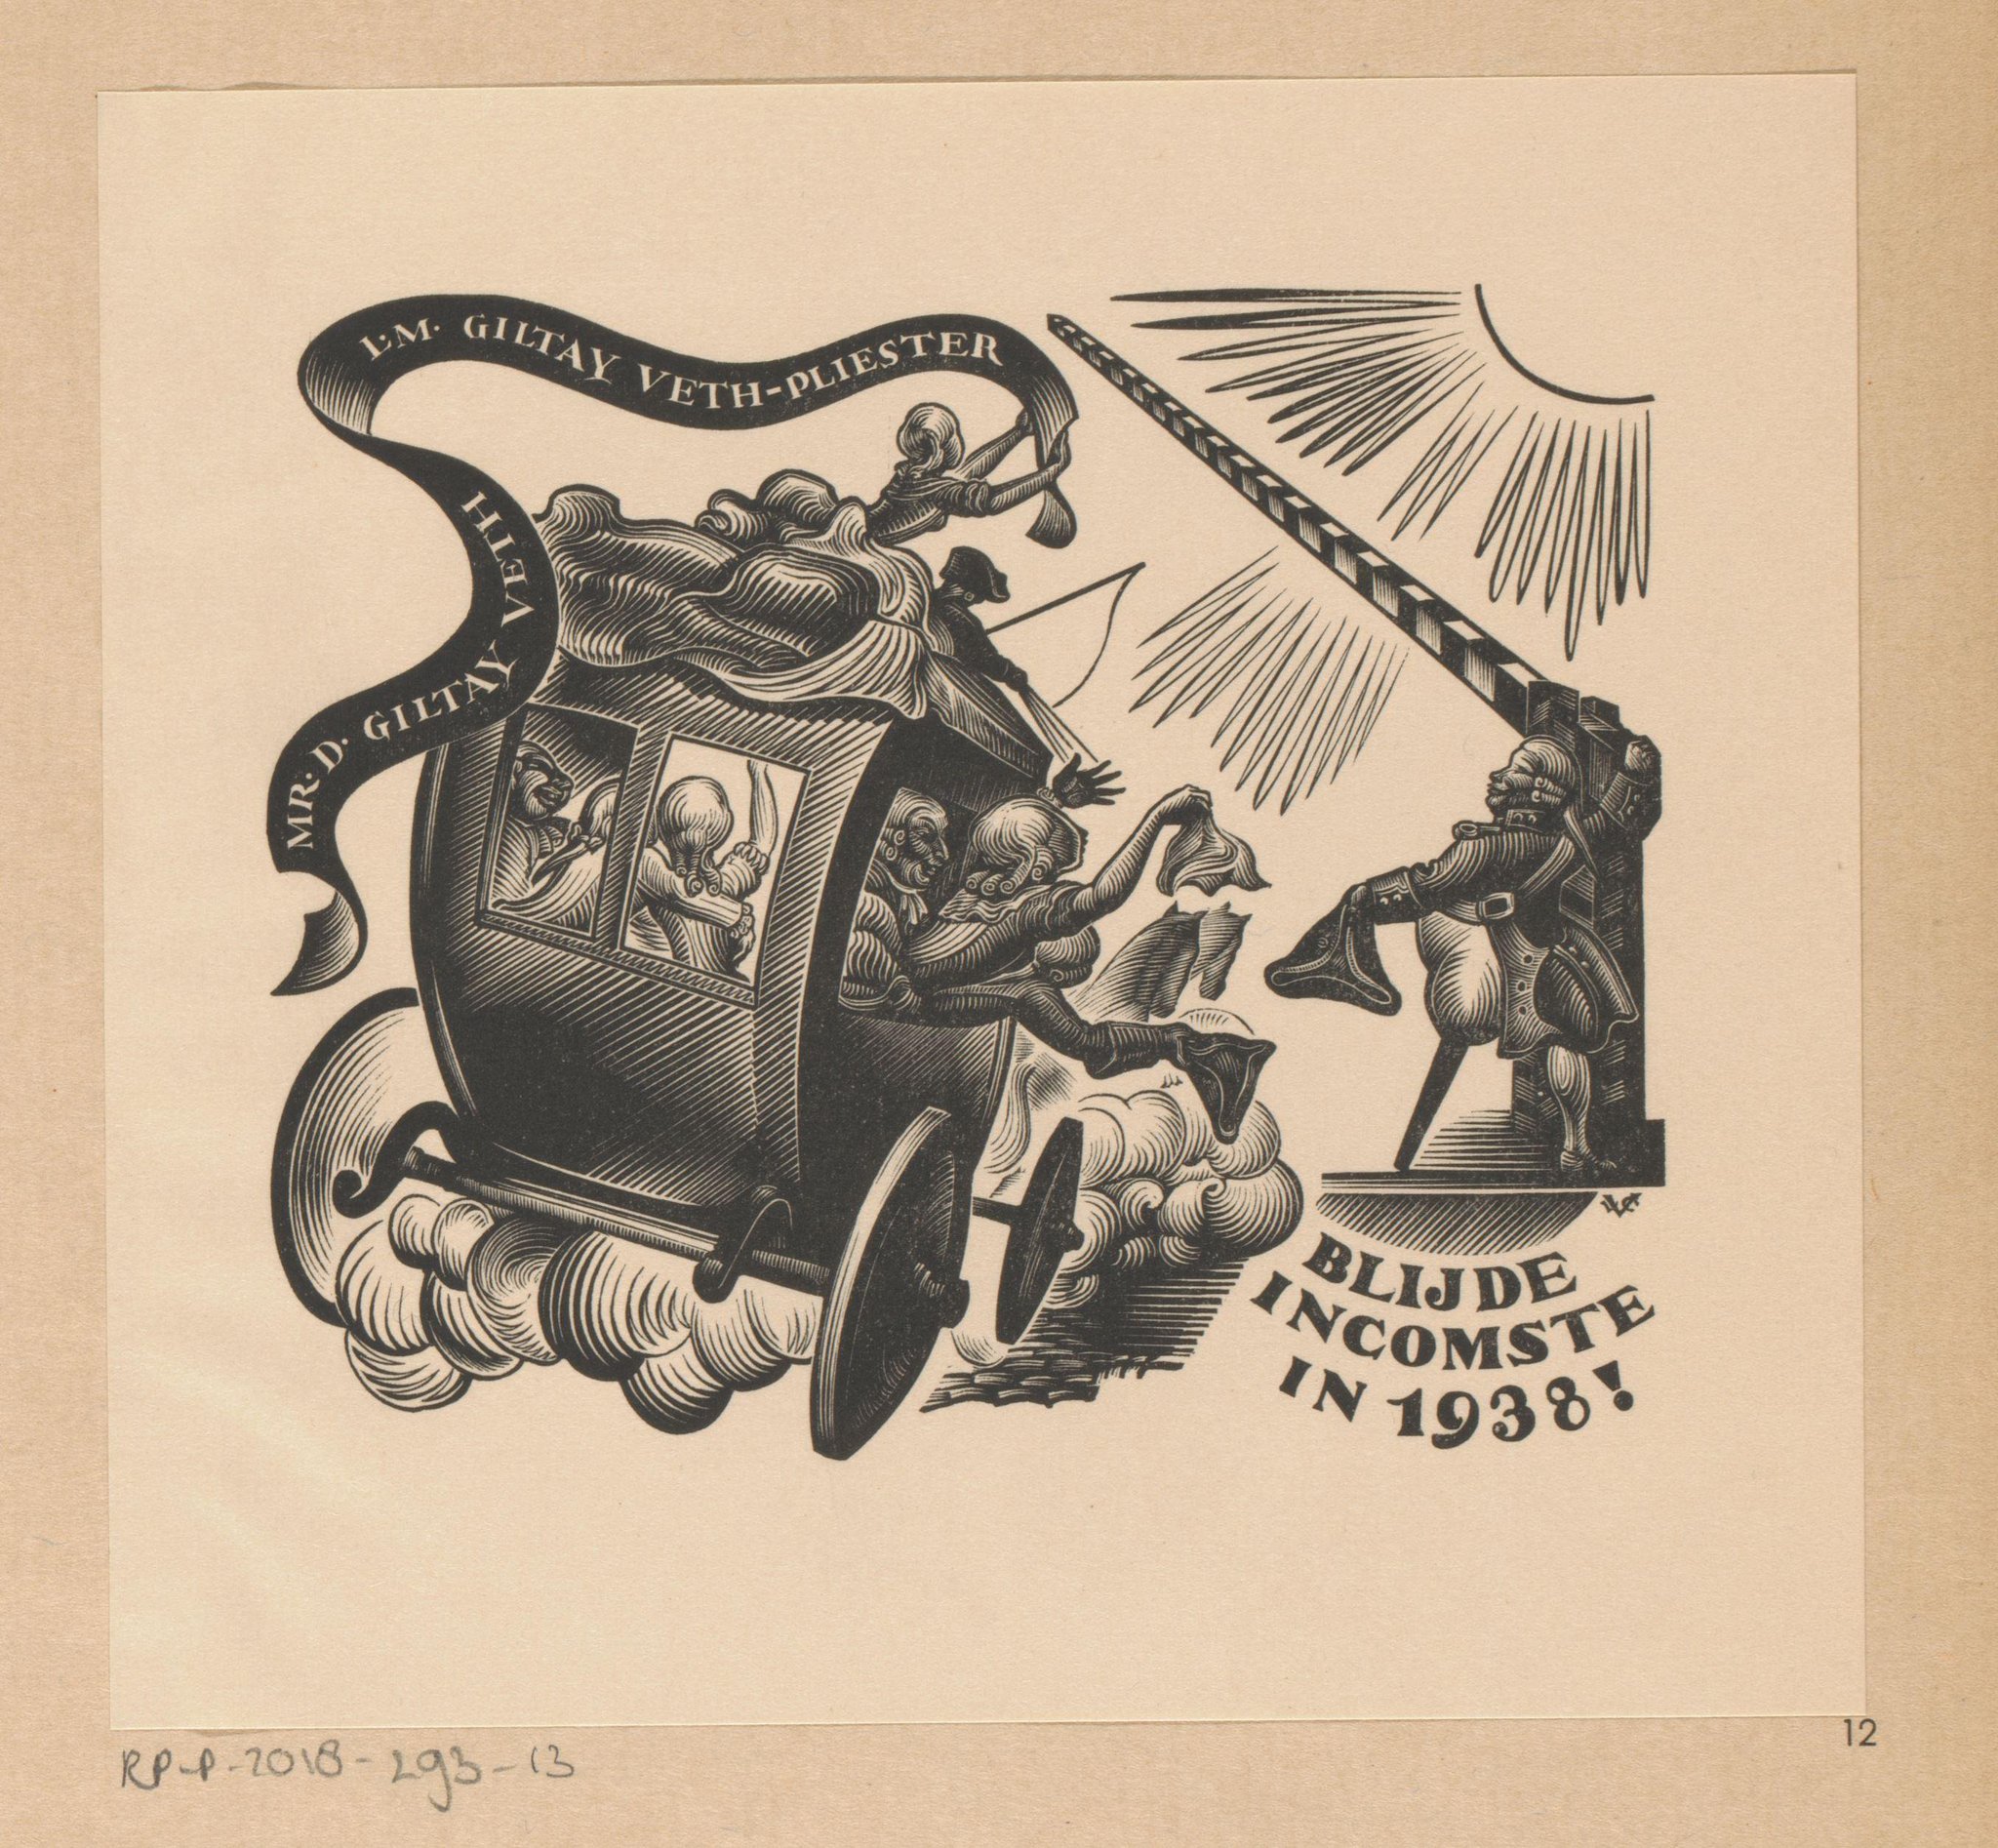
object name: new year card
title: Nieuwjaarswens van Daniël Giltay Veth en L.M. Giltay Veth-Pliester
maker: valentin le campion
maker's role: print maker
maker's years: 1861-1952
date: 1937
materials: paper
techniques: engraving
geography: france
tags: amsterdam, daniël giltay veth, barbed wire, four-wheeled, animal-drawn vehicle, e.g.: cab, carriage, coach, (military) uniforms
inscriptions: date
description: Deze prent maakt deel uit van een omslag met 22 prenten.